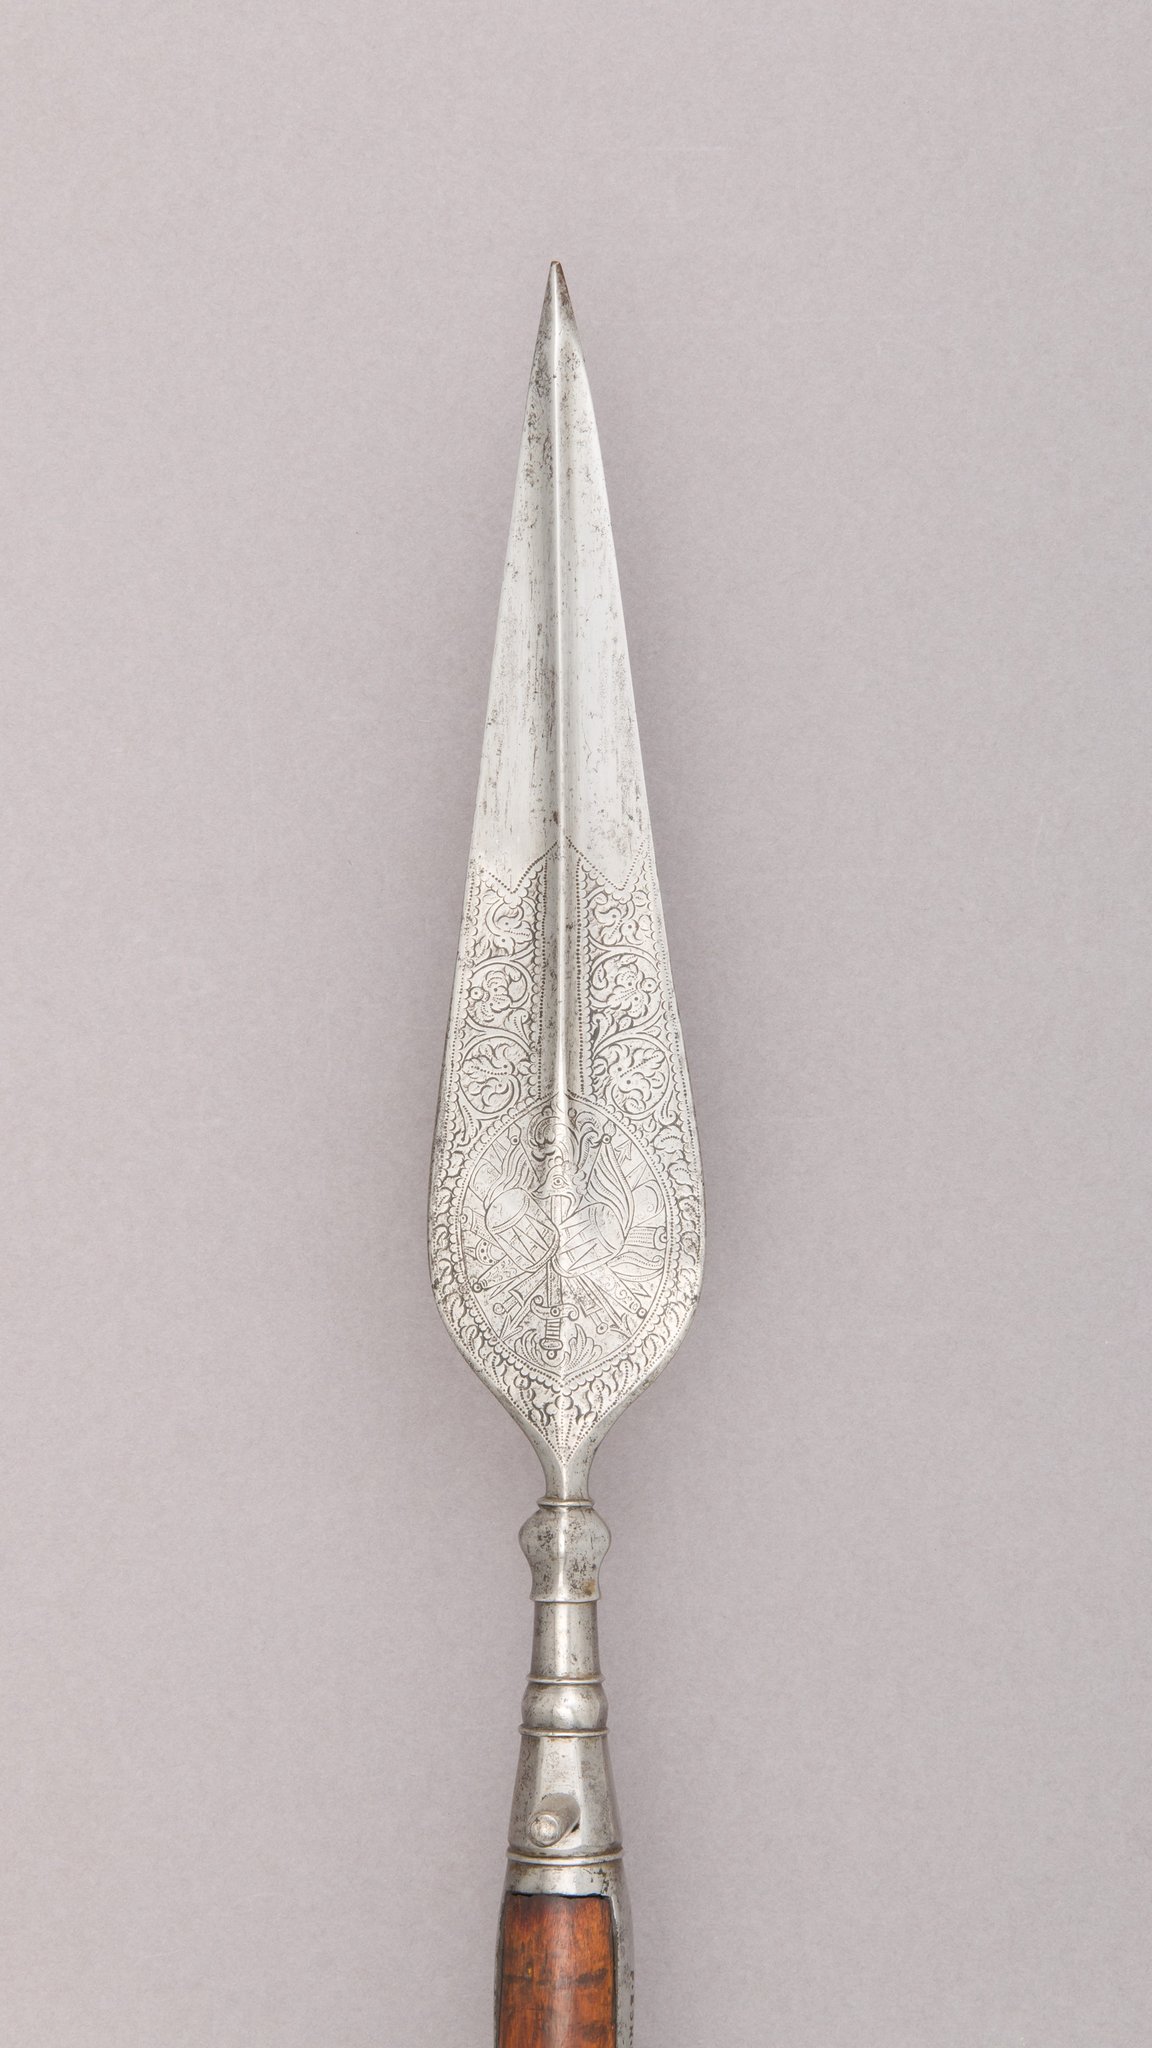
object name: spontoon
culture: french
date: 1601-1700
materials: iron, steel, wood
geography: france